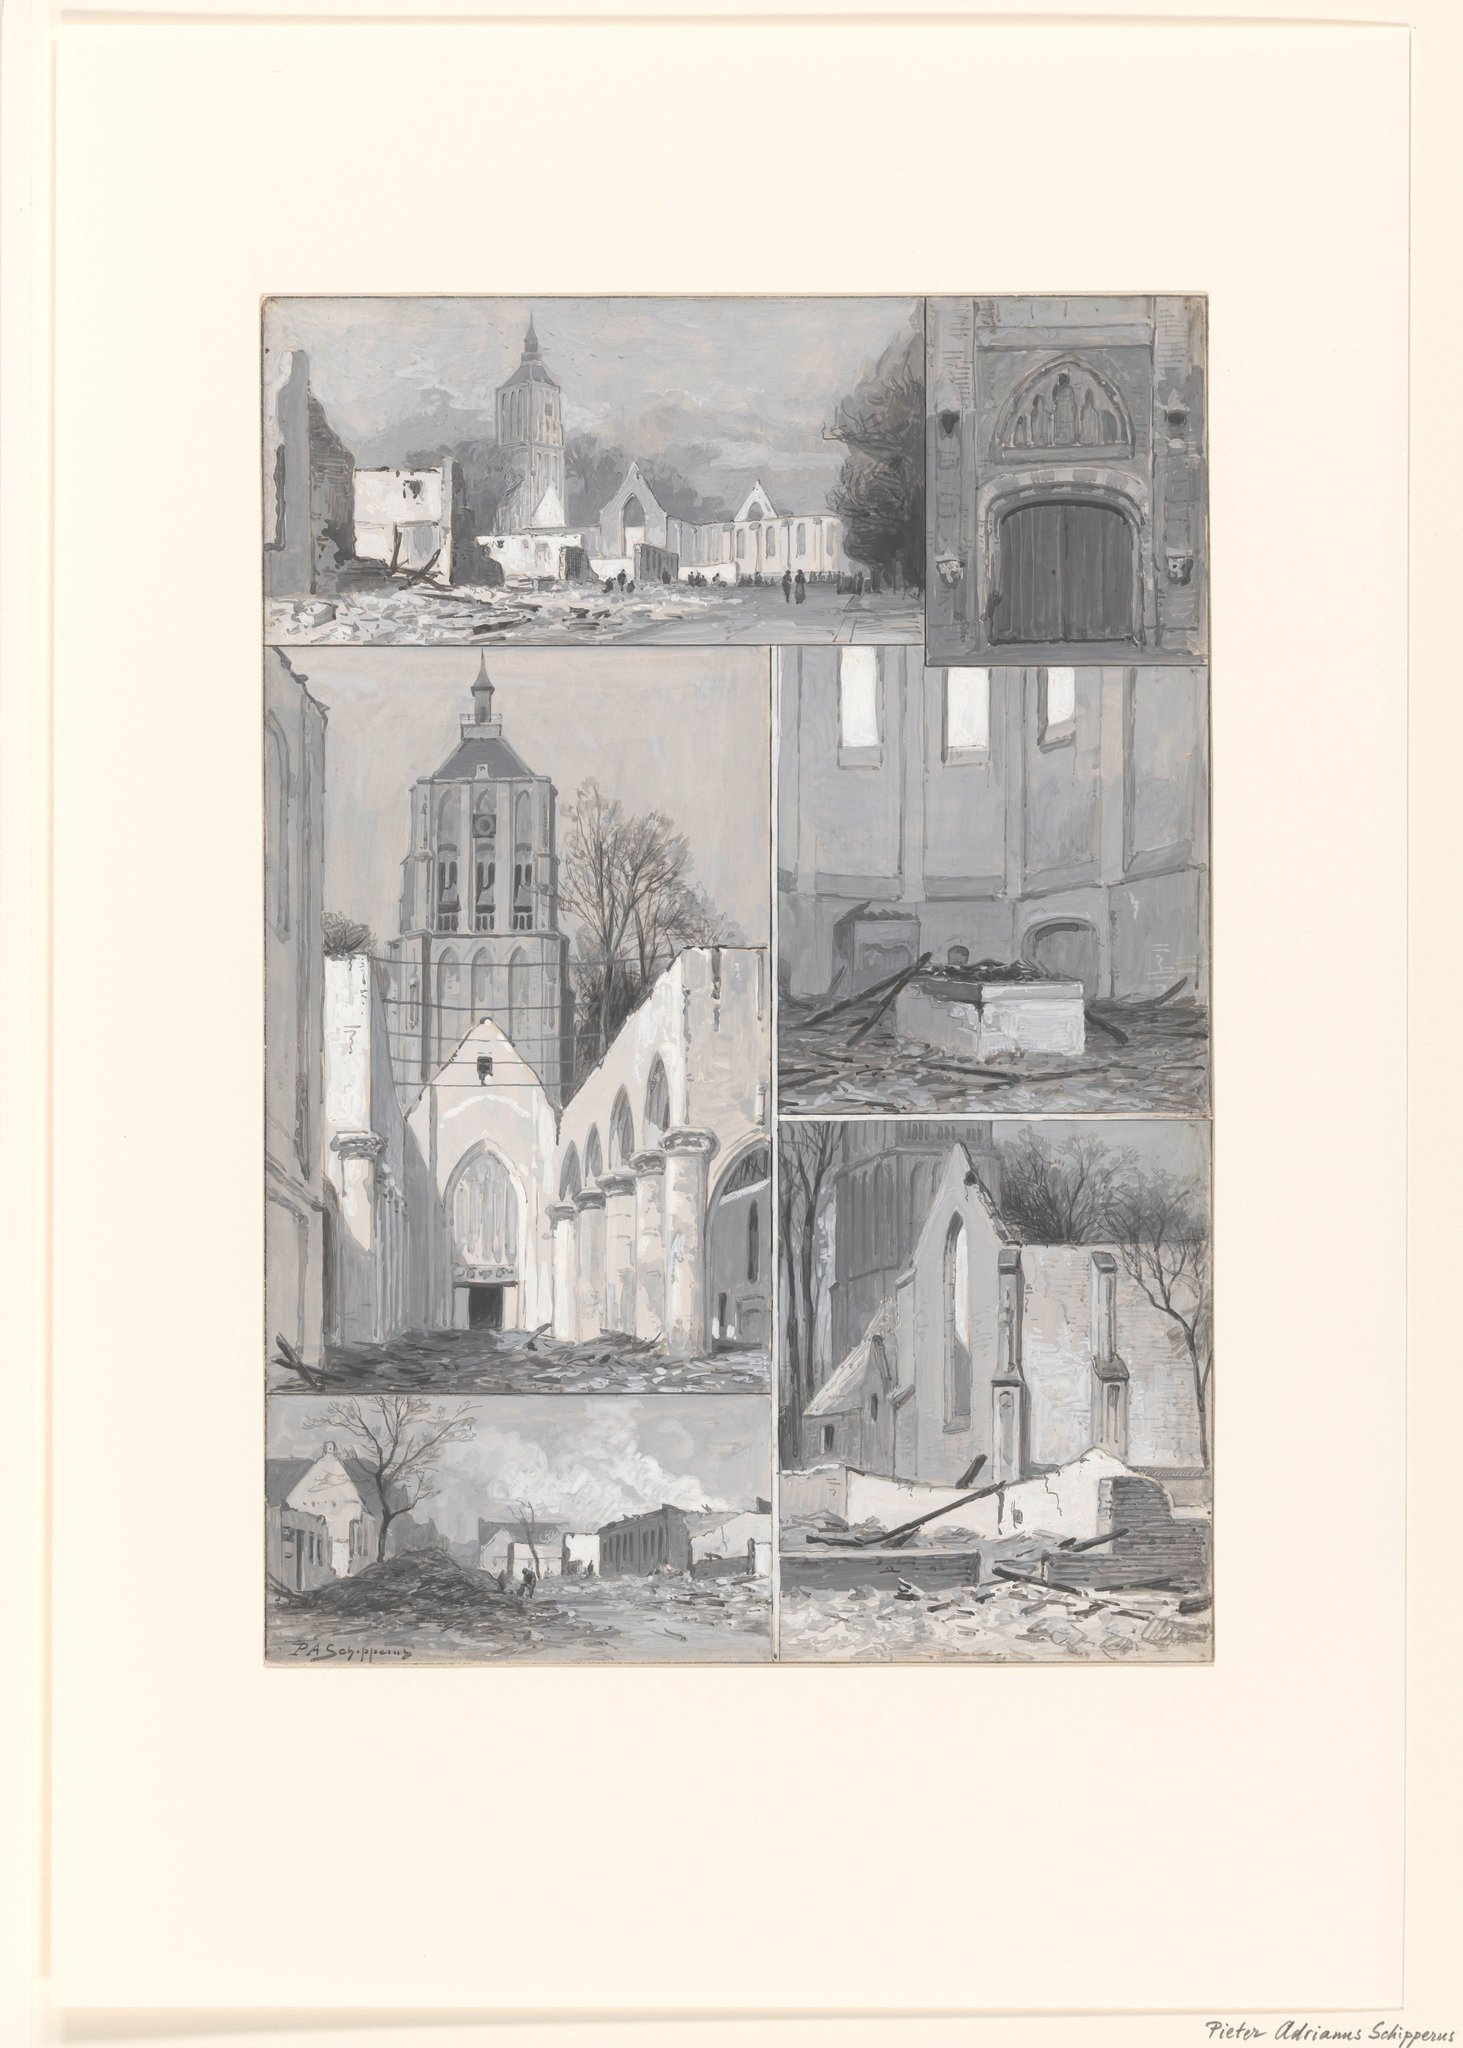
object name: drawing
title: Verschillende gezichten op en in de kerk van Asperen na een brand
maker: piet schipperus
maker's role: draughtsman, print maker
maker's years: 1840-1929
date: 1896-1908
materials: paint, paper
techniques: brush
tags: on fire, ablaze, ruin of a building ~ architecture, church (exterior), asperen